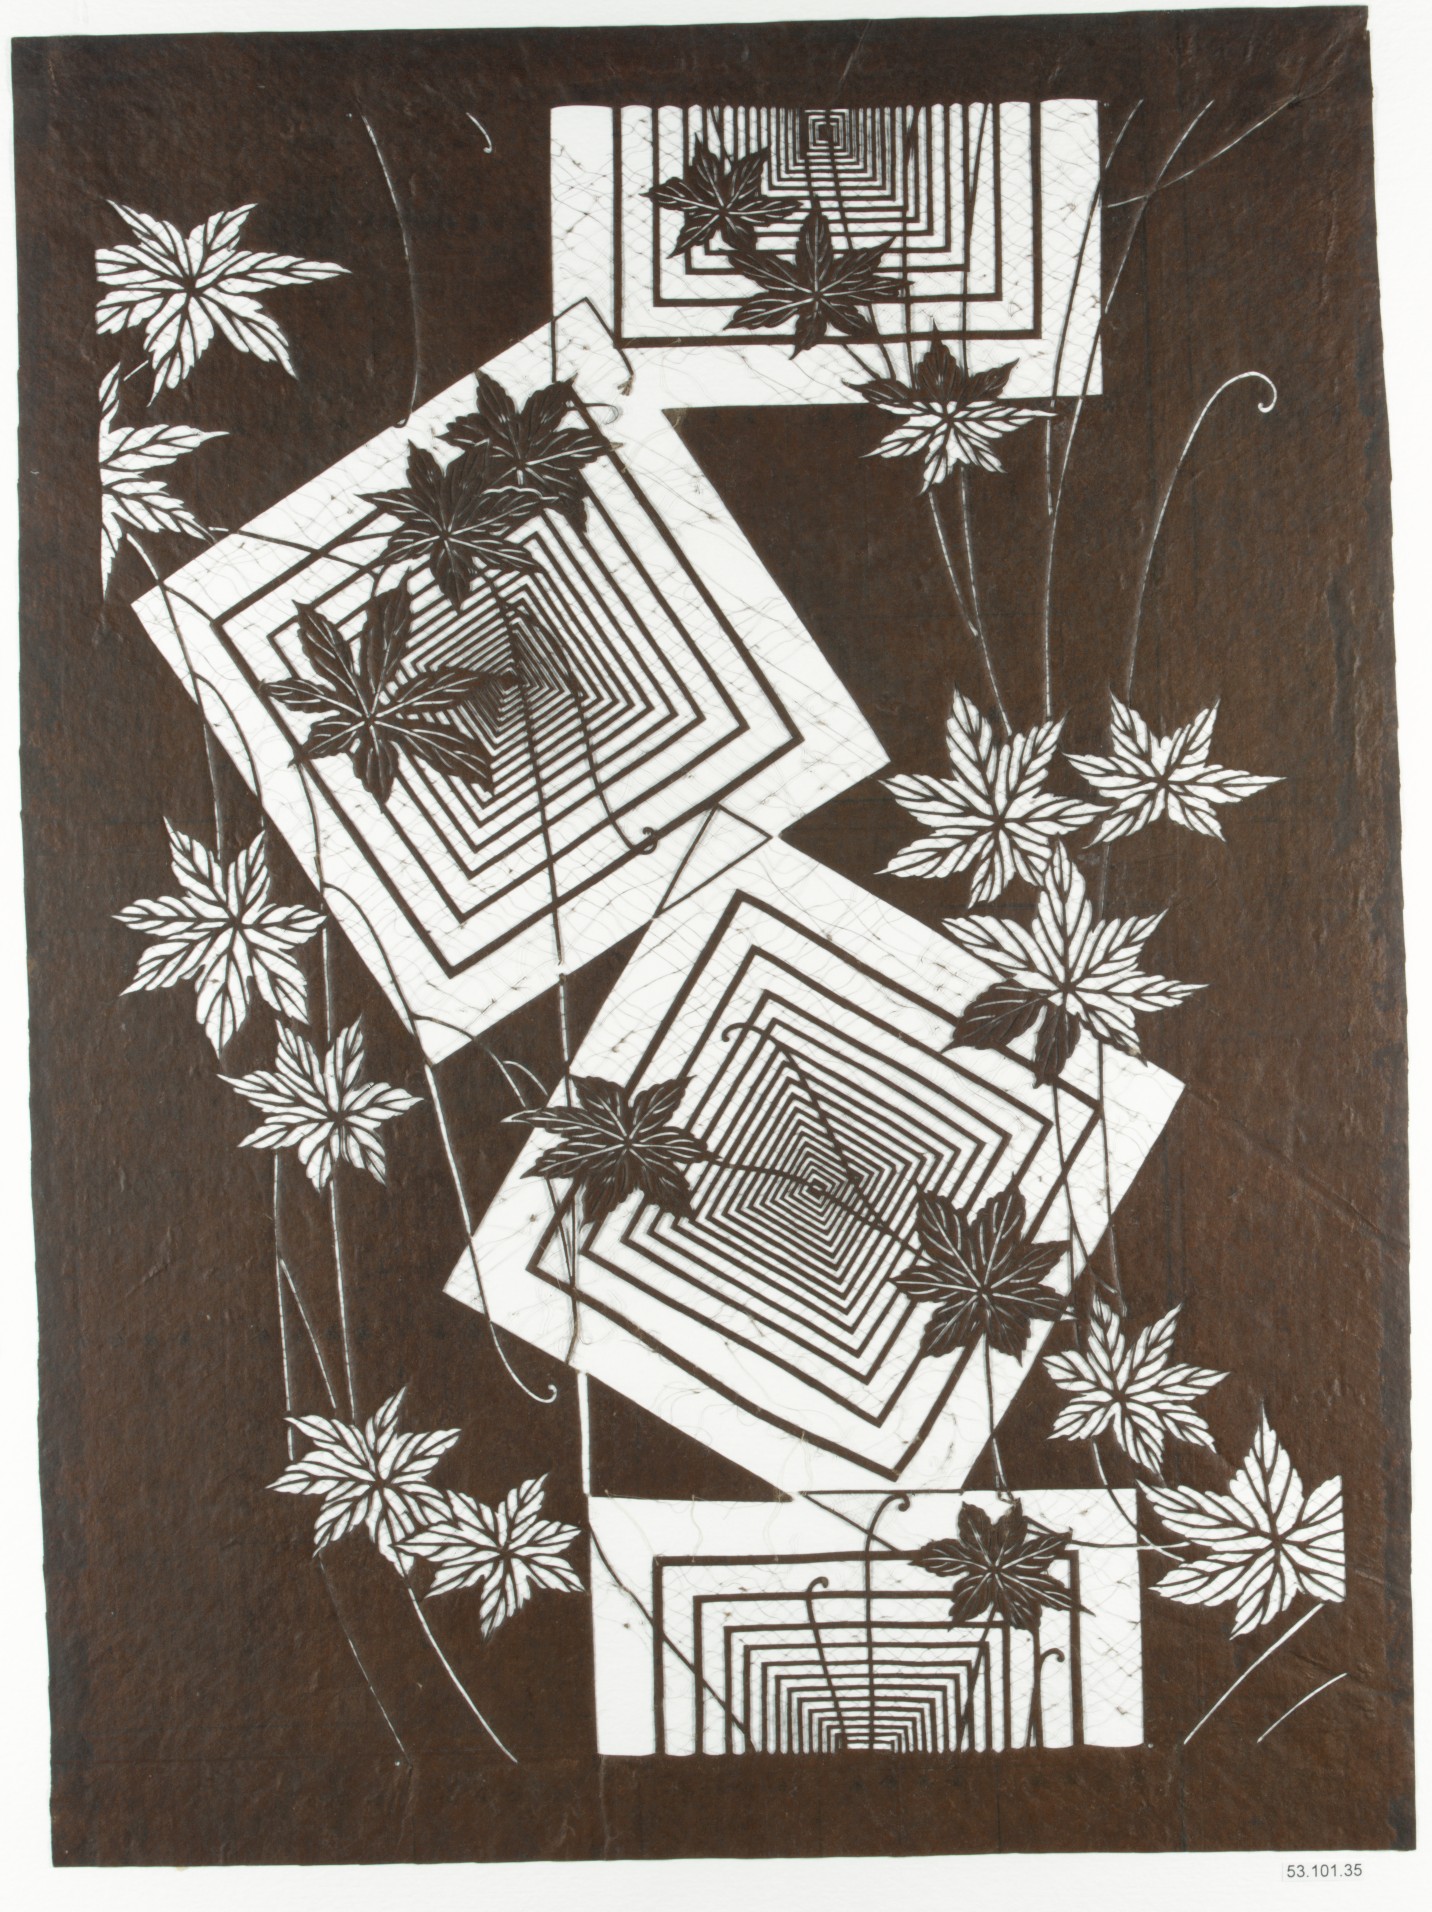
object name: stencil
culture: japanese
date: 1615-1868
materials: paper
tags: leaves